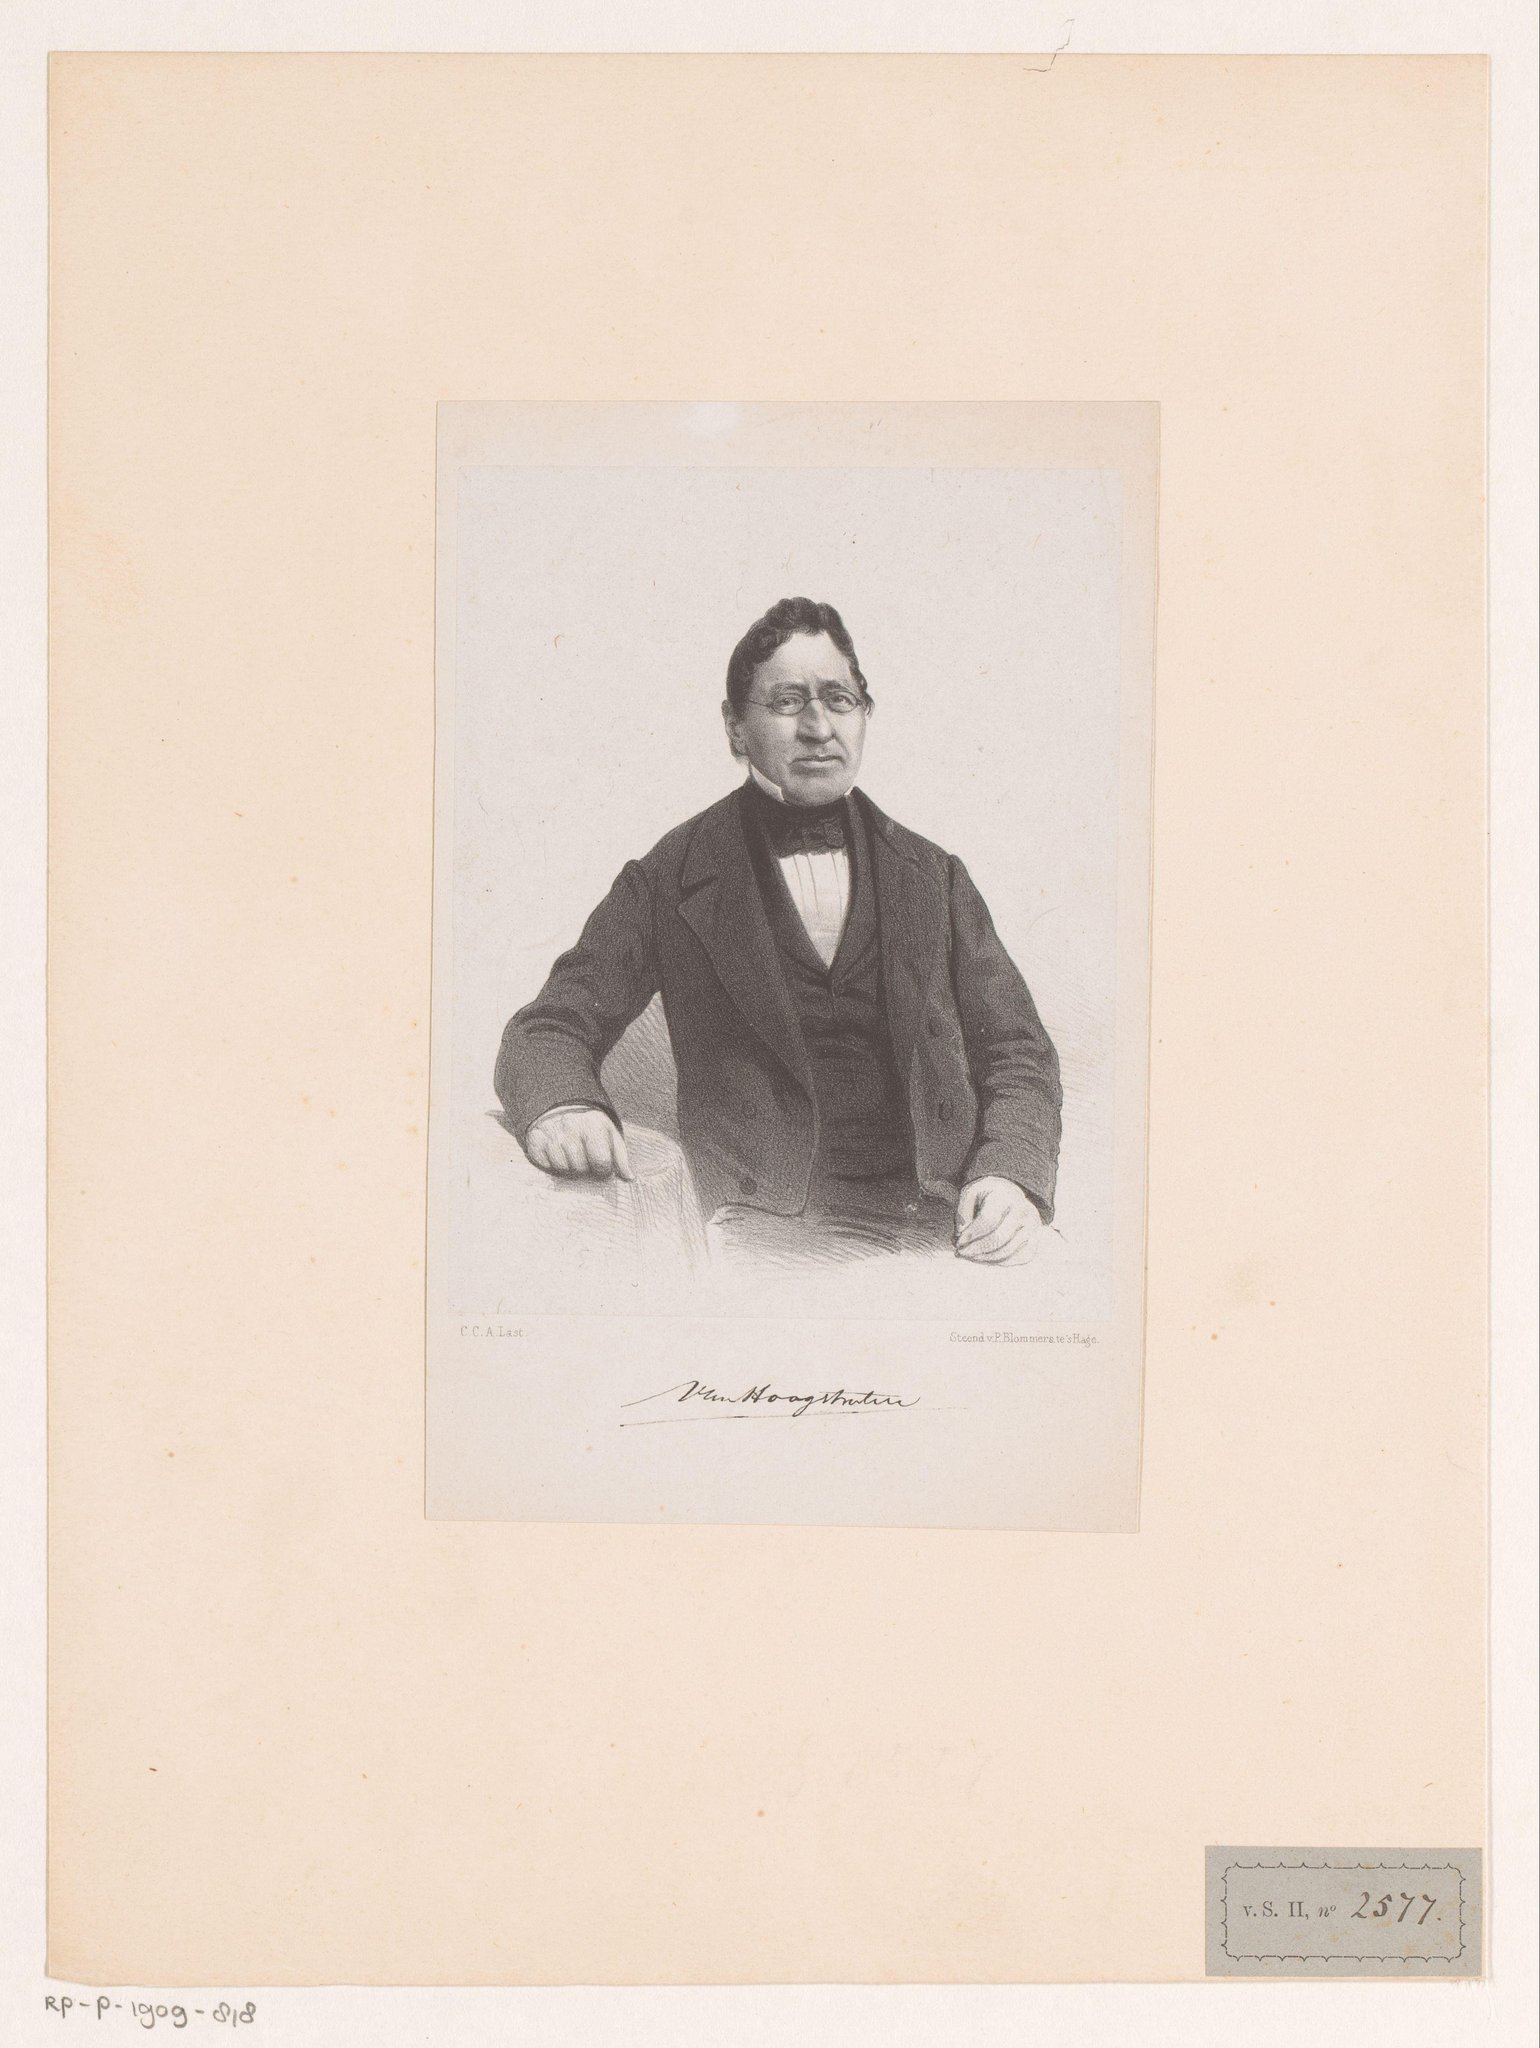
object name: print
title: Portret van Jurianus Hensbergen van Hoogstraten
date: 1861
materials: paper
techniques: lithograph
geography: the hague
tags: historical persons (+ half-length portrait)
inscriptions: collector's mark: Lugt 2228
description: De geportretteerde draagt een bril. Onder het portret zijn signatuur.